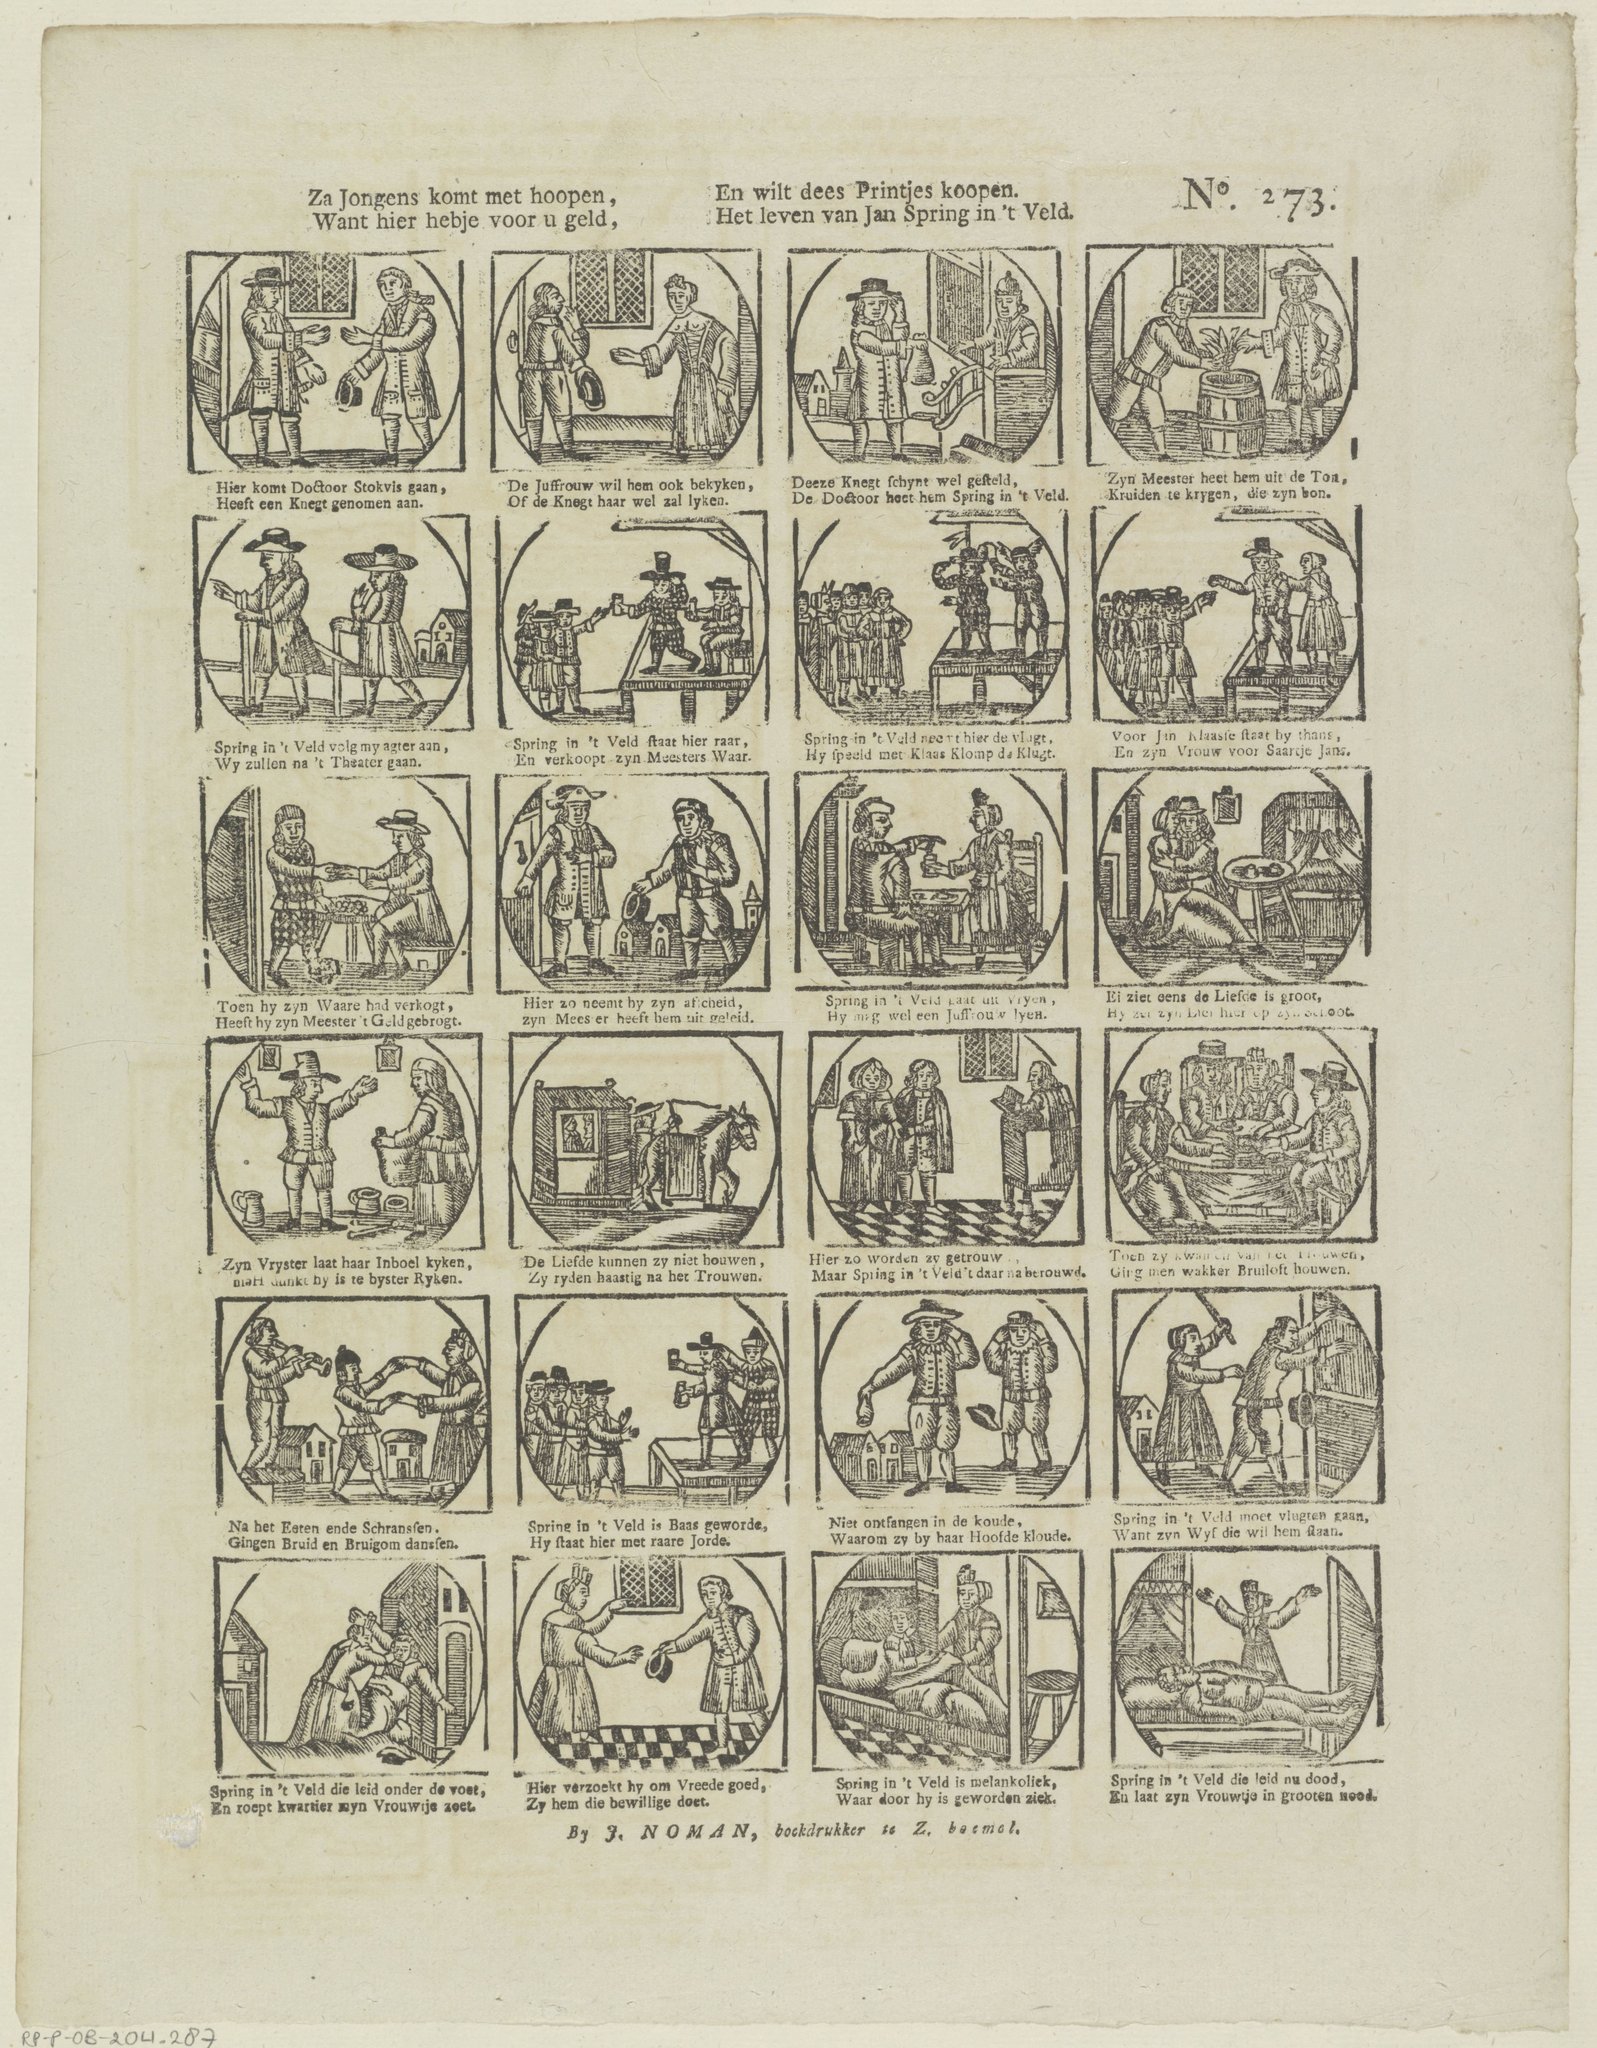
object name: popular print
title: Za jongens komt met hoopen, / En wilt dees printjes koopen. Want hier hebje voor u geld, / Het leven van Jan Spring in 't Veld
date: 1806-1830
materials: paper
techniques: letterpress printing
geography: netherlands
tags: quack, charlatan, mountebank, 'saltimbanco', marriage, married couple, 'matrimonium', tales and fairy tales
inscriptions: collector's mark: Lugt 2760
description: Blad met 24 voorstellingen over het leven van Jan Spring in 't Veld. Onder elke afbeelding een tweeregelig vers. Genummerd rechtsboven: No. 273.